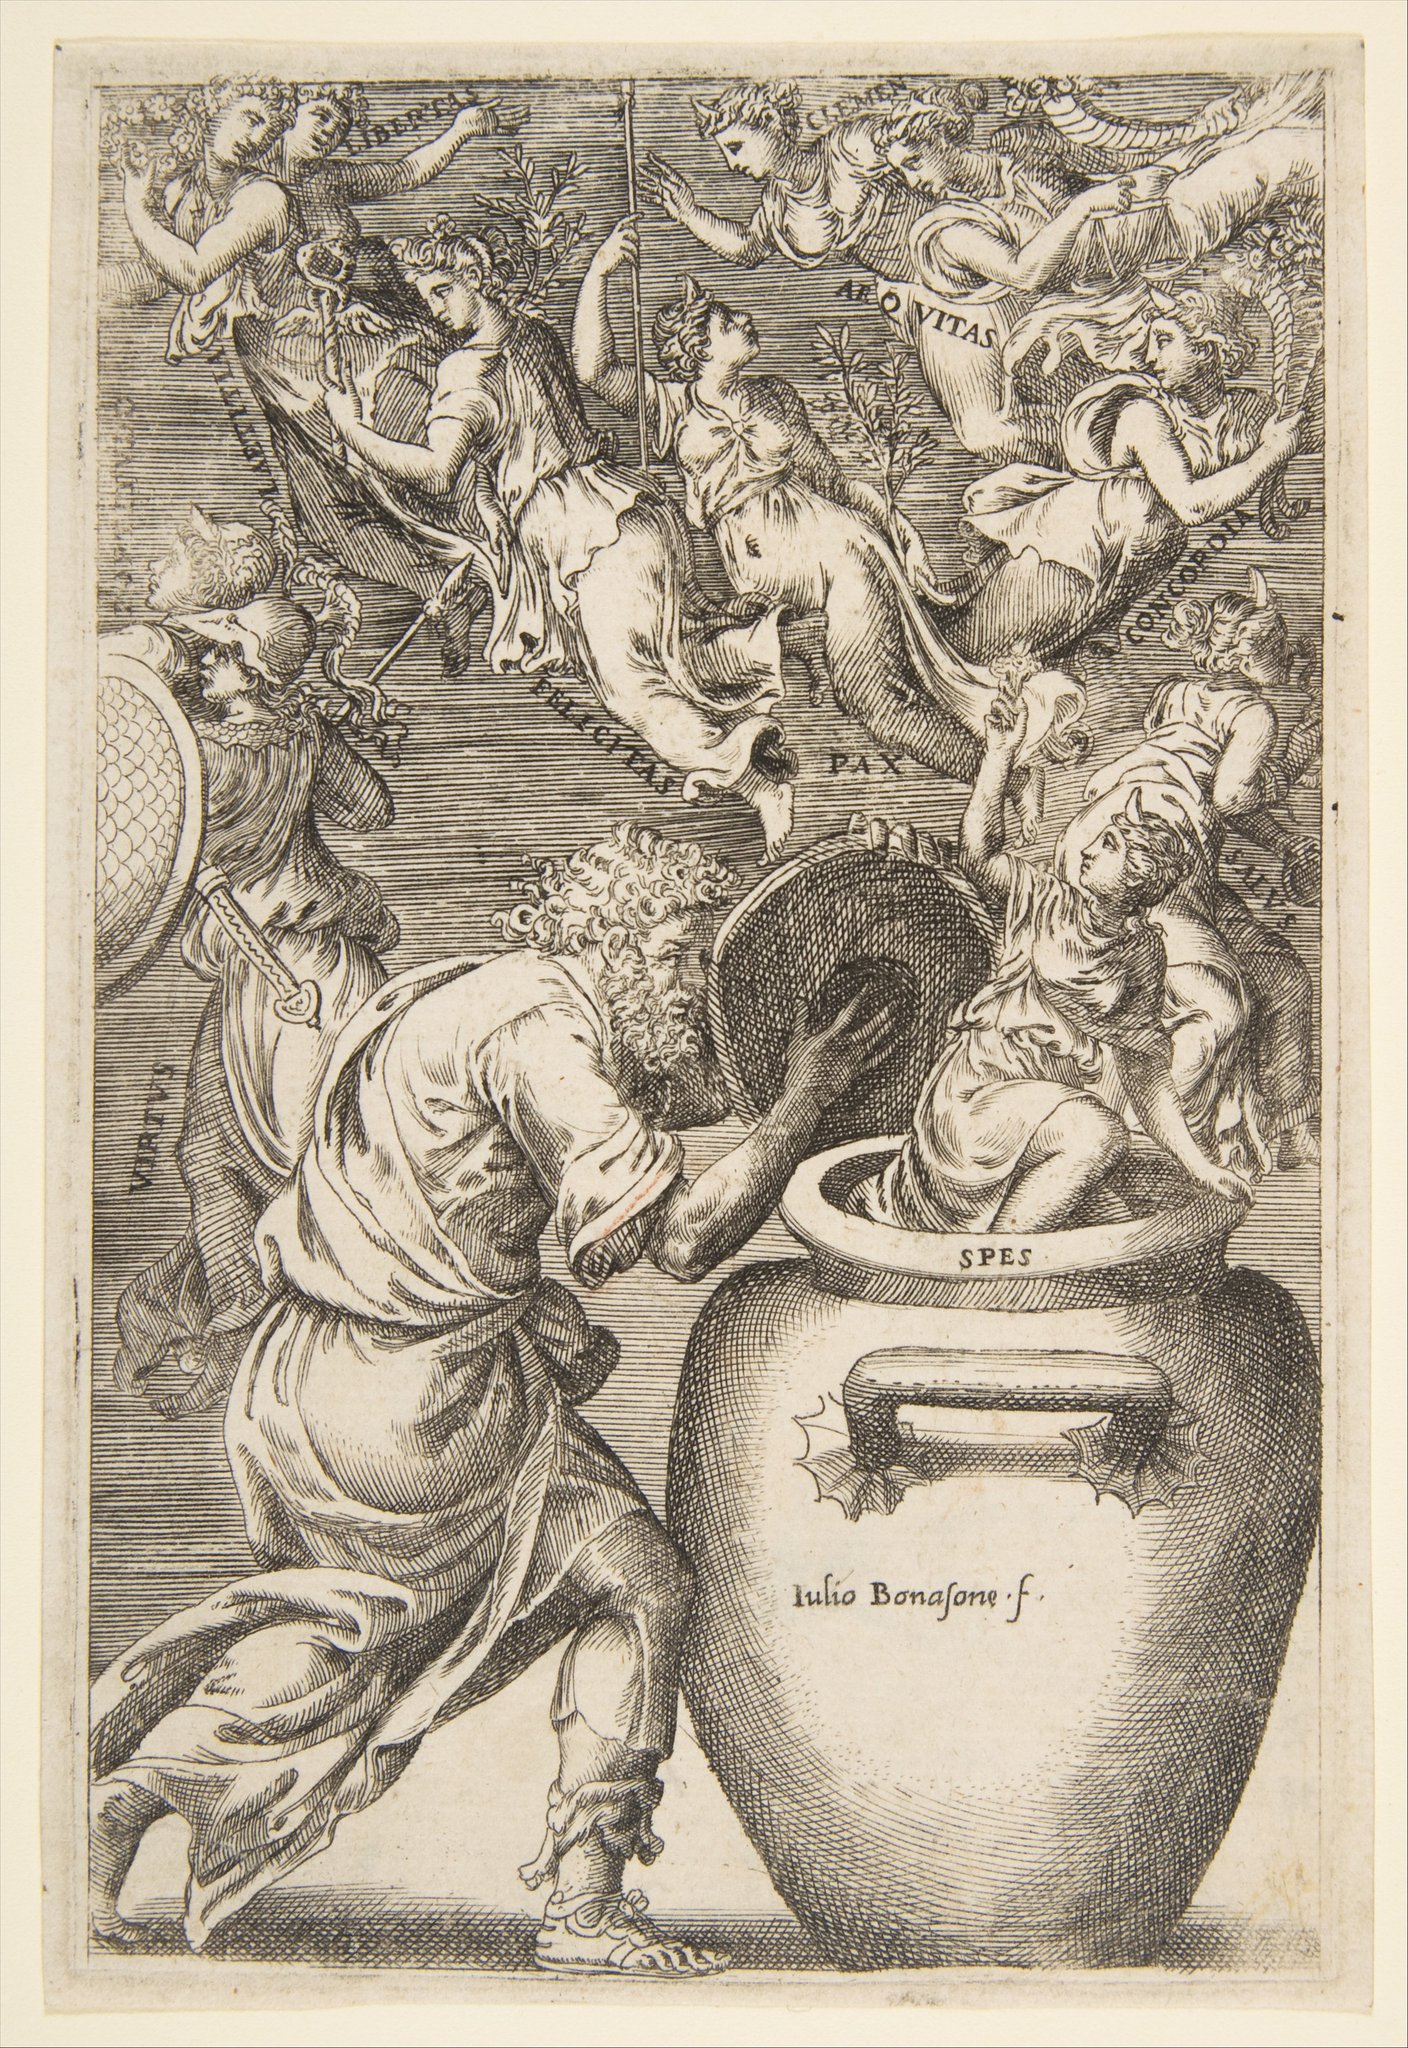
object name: print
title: Epimetheus opening Pandora's box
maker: giulio bonasone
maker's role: artist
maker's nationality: italian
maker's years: 1510-1576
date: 1531-1576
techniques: engraving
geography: providence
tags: men,women